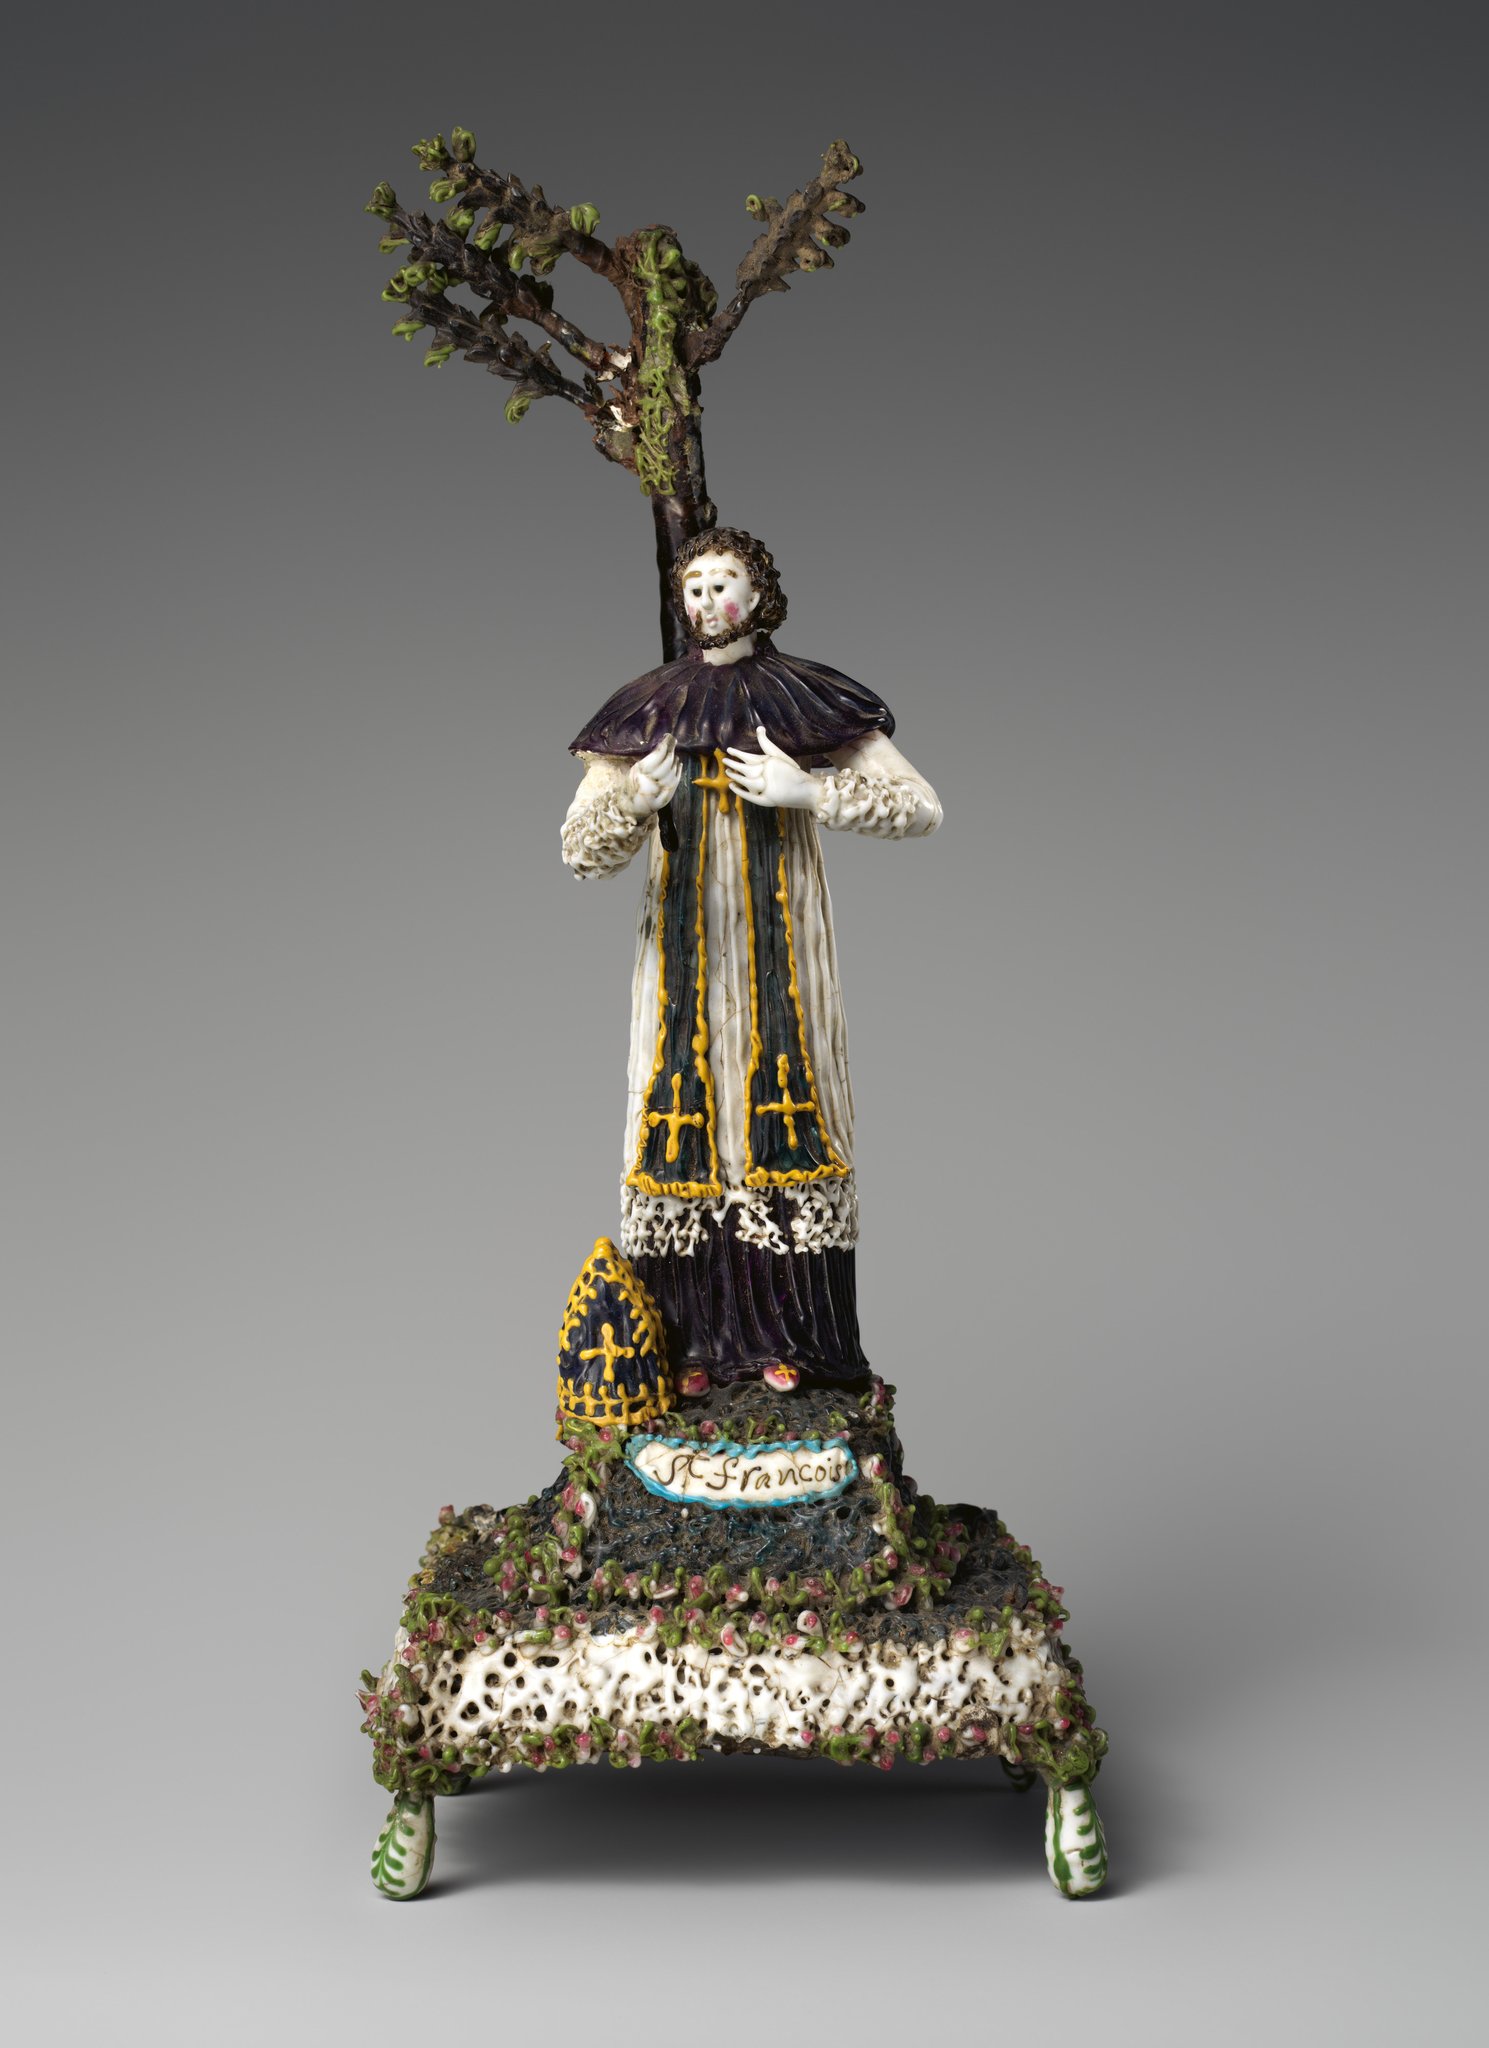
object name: figurine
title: Saint Francis de Sales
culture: french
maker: haly workshop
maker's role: artist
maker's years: 18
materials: gemstone, copper, glass, iron, metal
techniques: lampwork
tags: men